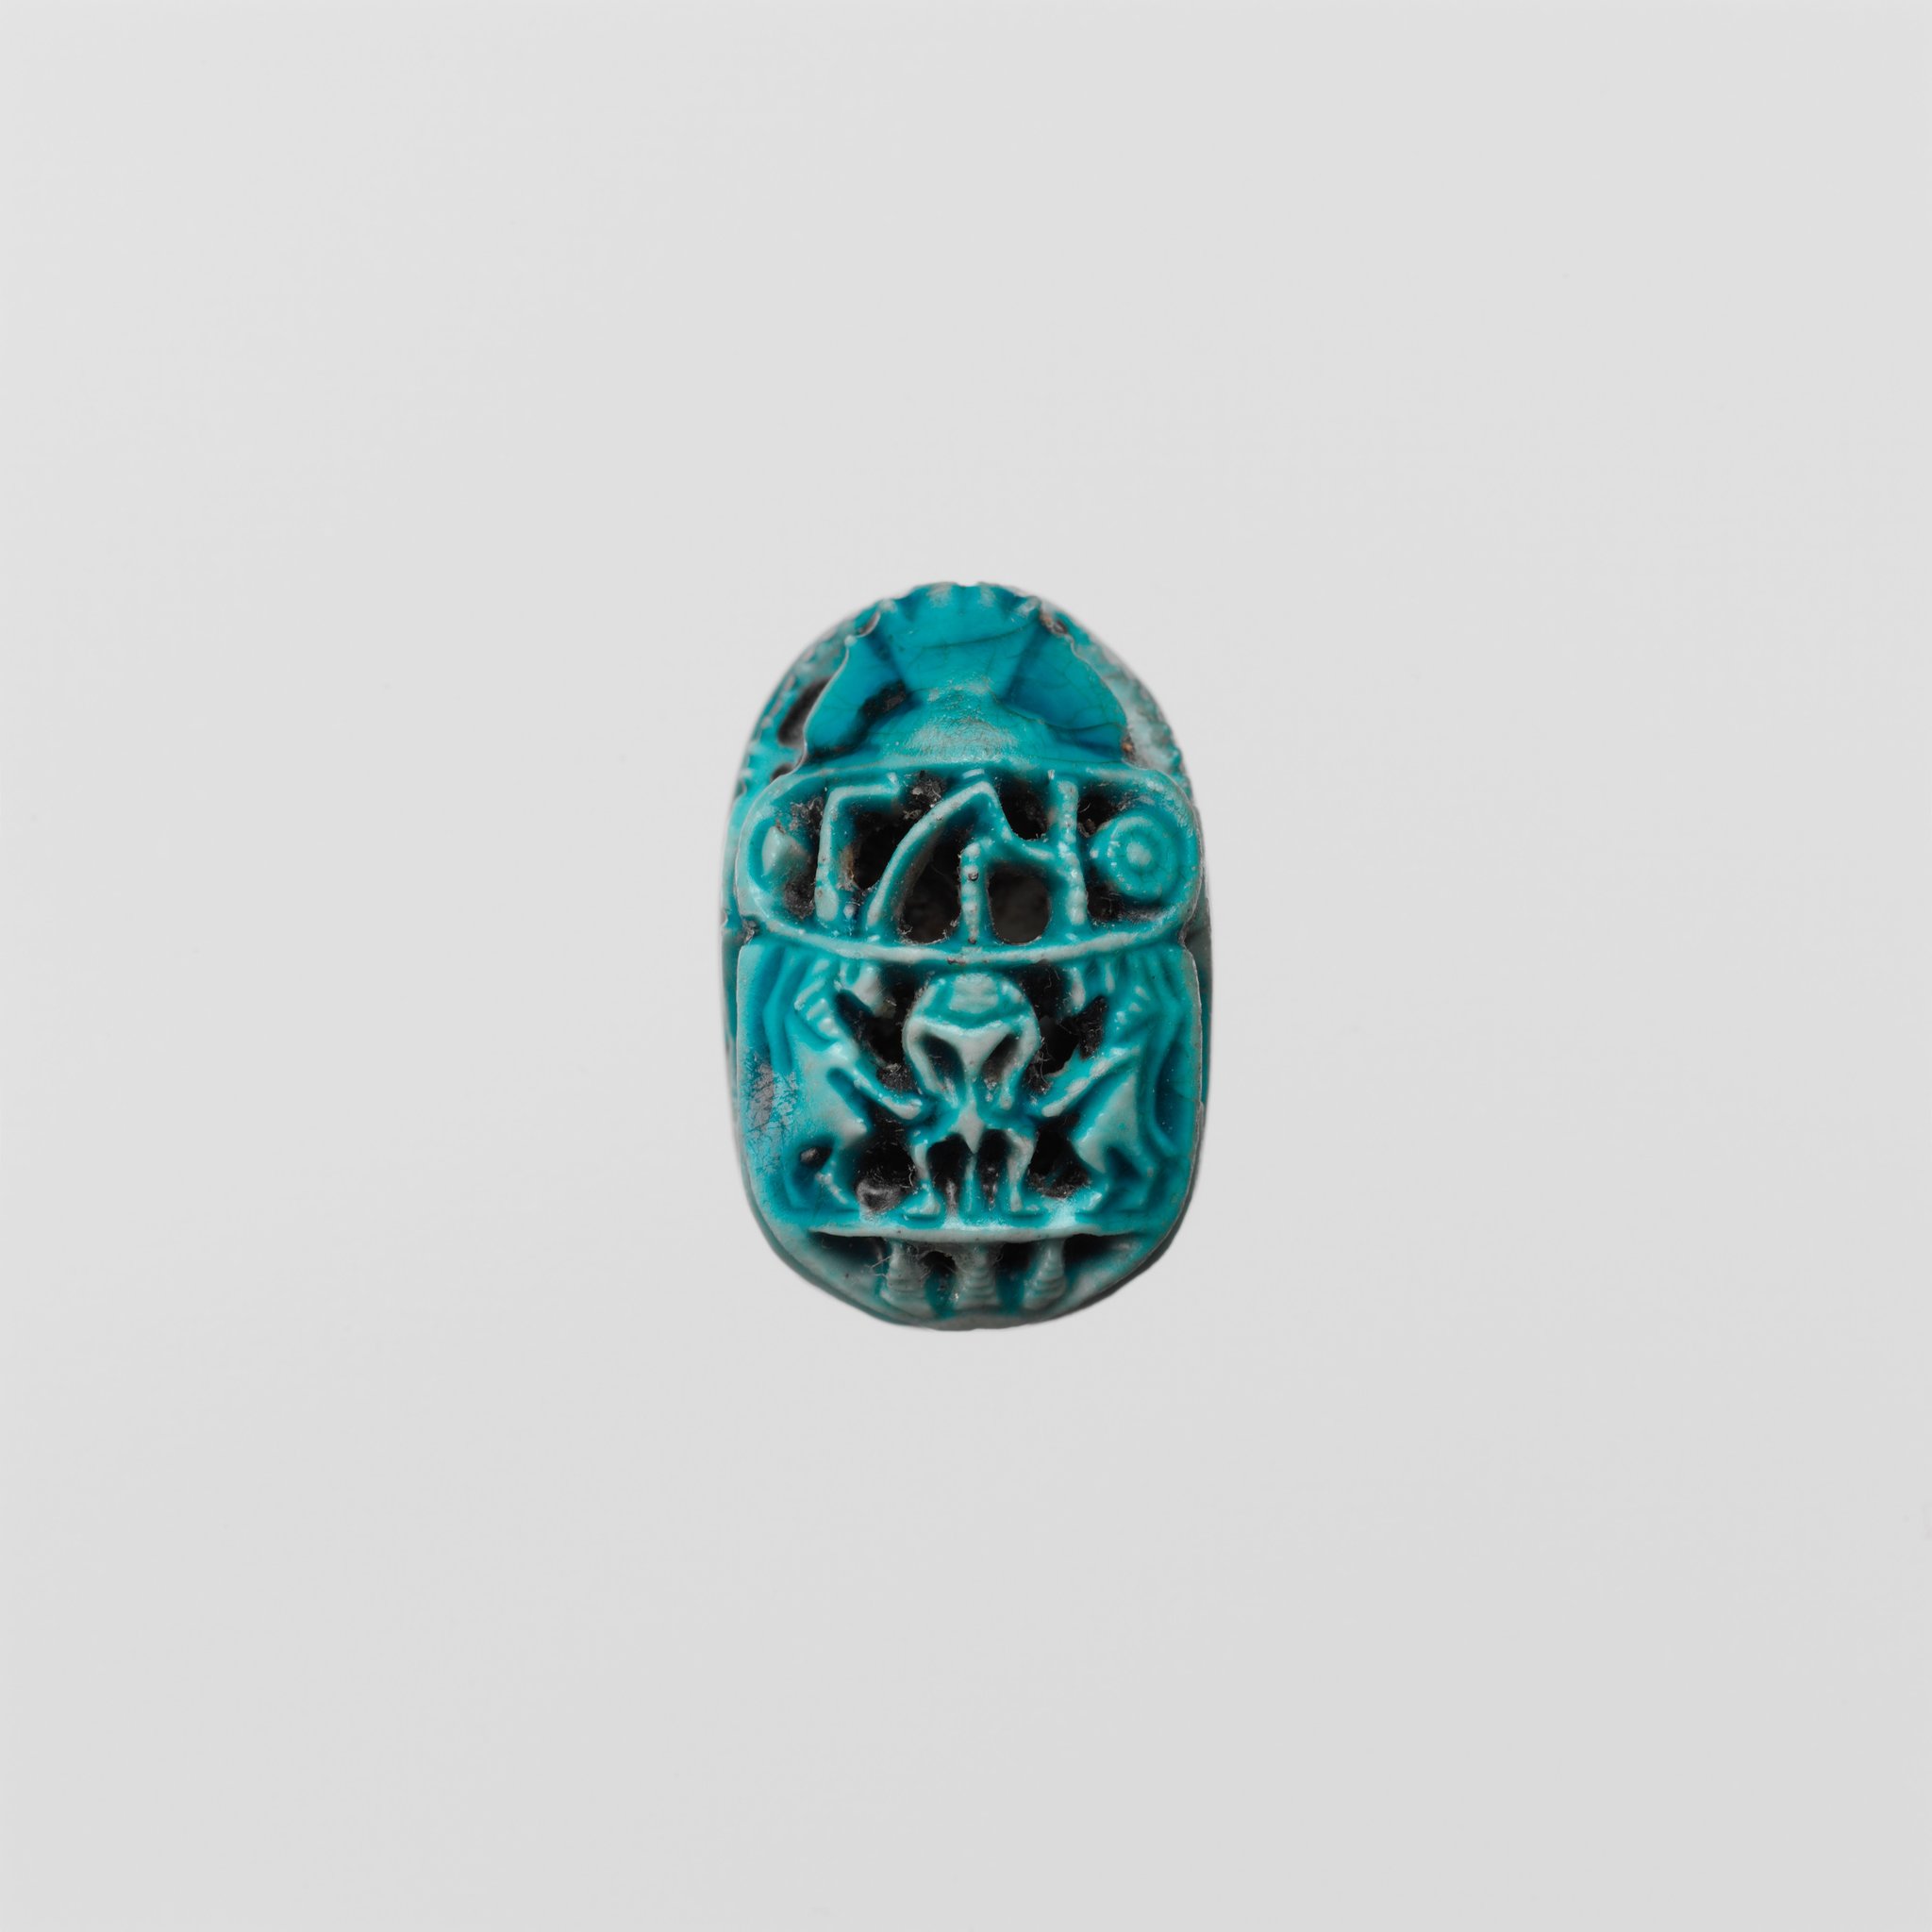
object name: scarab, amenemhat iii, openwork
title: Scarab with the Name of Amenemhat III and a Hippopotamus Hunt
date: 1859-1749 BCE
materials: stone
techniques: glazing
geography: memphite region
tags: hunting,hippos